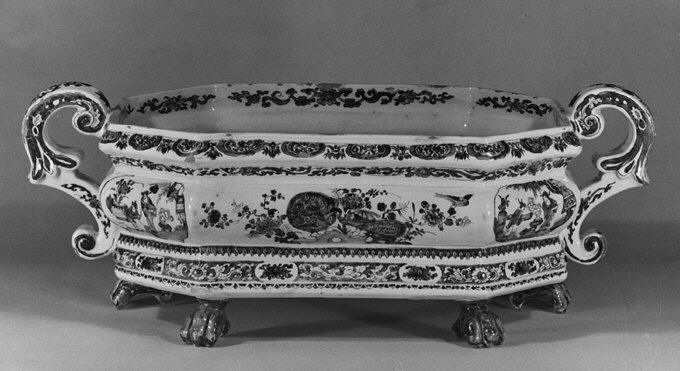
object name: wine cistern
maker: de metaale pot factory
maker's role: factory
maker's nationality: dutch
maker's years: 1670-1775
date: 1667-1733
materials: earthenware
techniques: glazing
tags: human figures,peacocks,flowers